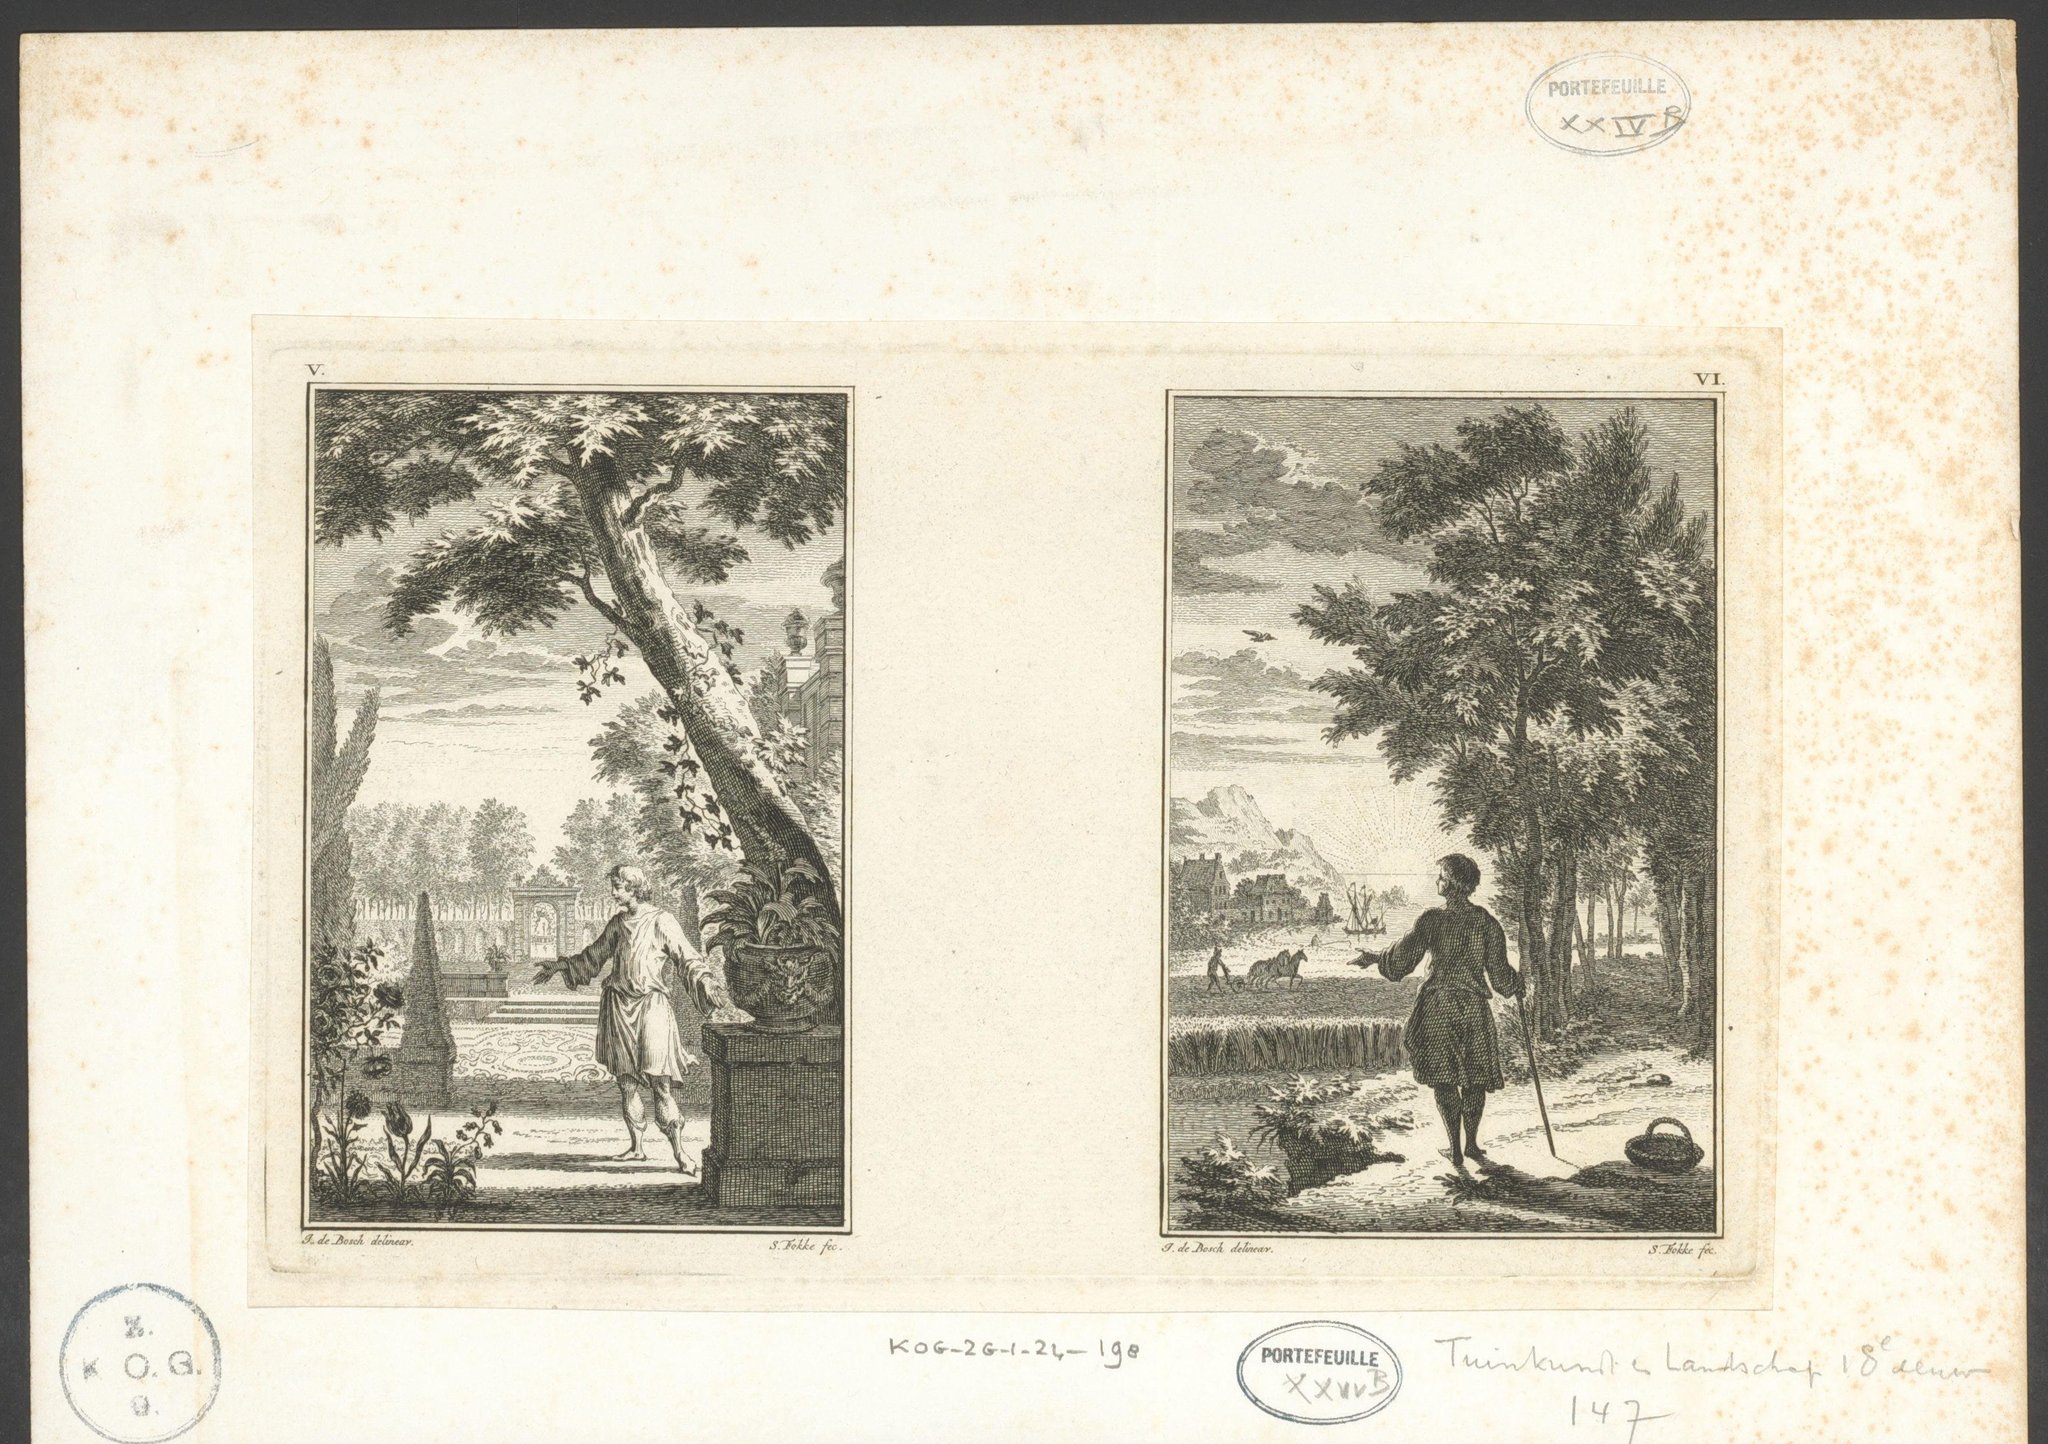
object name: print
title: Twee mannen in een tuin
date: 1754-1765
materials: paper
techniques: etching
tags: garden, sunset, landscapes - hh - ideal landscapes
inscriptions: collector's mark: Lugt 1641, stamp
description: Twee afbeeldingen gedrukt van een plaat. Links op een tuinpad staat een man met geheven armen onder een boom. Achter hem ligt een aangelegde tuin met terras en zorgvuldig geschoren hagen. Rechts een landschap met ondergaande zon, in de verte bewerkt een boer met een ploeg het land en ligt even verderop een boot in de baai. Op de voorgrond staat een wandelaar, op de rug gezien, die het landschap aanschouwt. Bovenaan genummerd: V. en VI. Onderwerpsrubrieken binnen de Atlas Zeden en Gewoonten: Zeden en Gewoonten in Engeren Zin, De Woning, Oude Nederlandsche Tuinkunst. De 18de eeuw. Tuinen in de Zaanstreek.